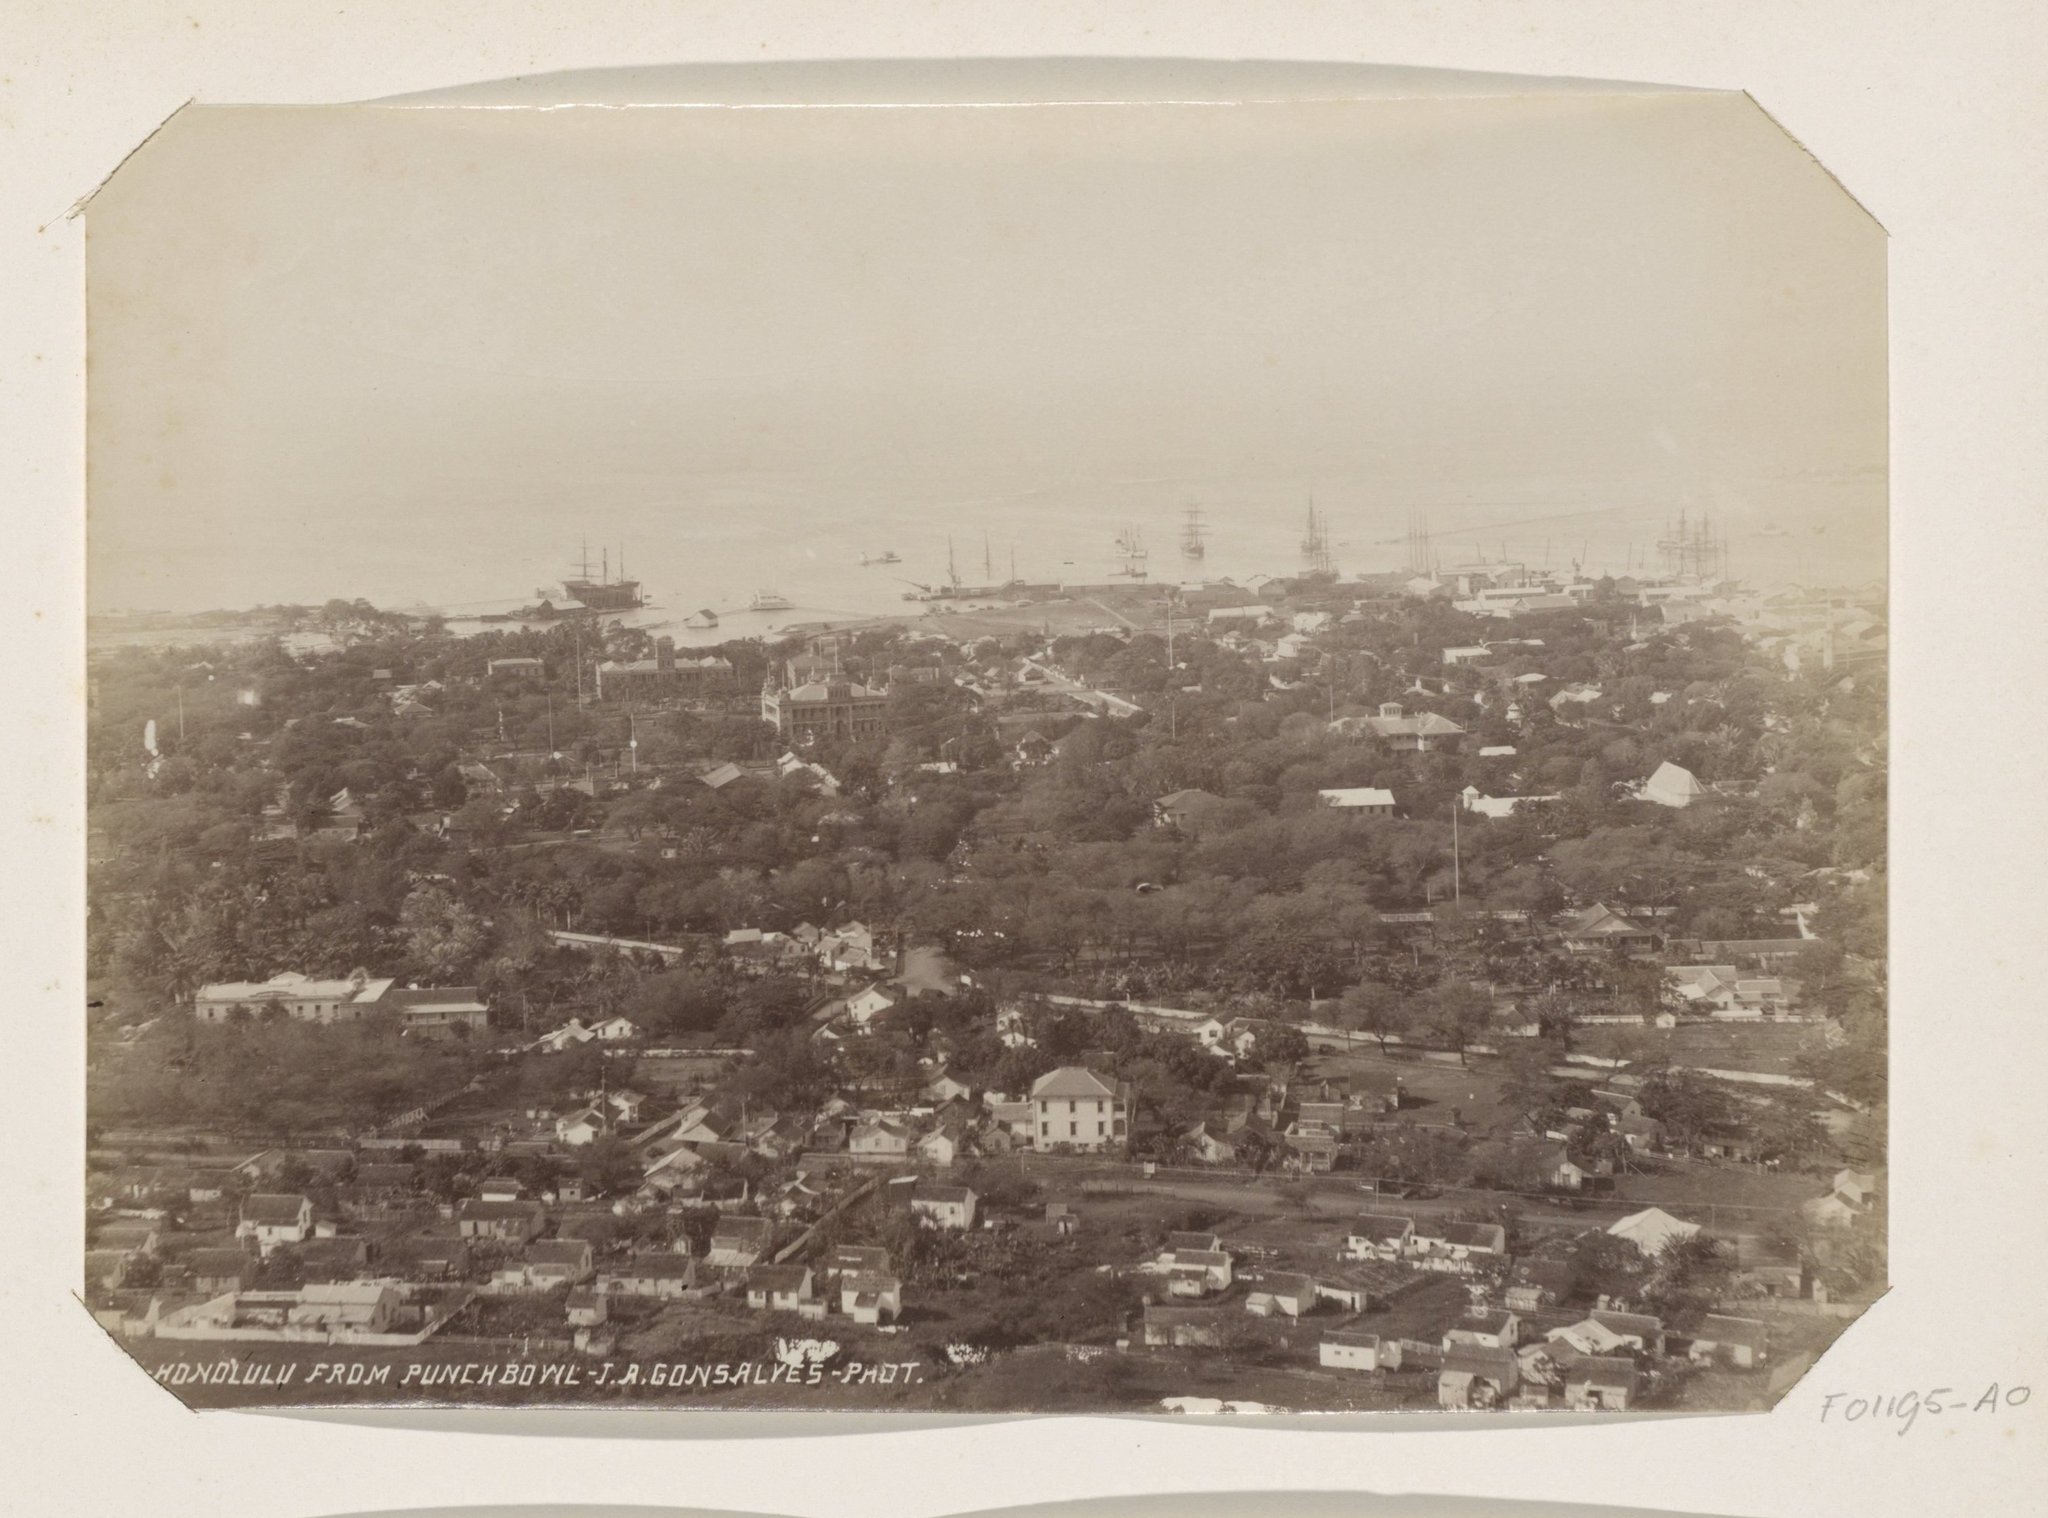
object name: photograph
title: Honolulu from Punchbowl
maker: j.a. gonsalves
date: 1860-1900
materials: cardboard, paper, photographic support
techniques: albumen print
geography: honolulu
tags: island, city-view in general; 'veduta'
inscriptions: negative number: ‘40’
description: Onderdeel van Fotoalbum van een reis door de Verenigde Staten, Honolulu, Nederlands-Indië, Aden, Zanzibar en Zuidelijk Afrika.